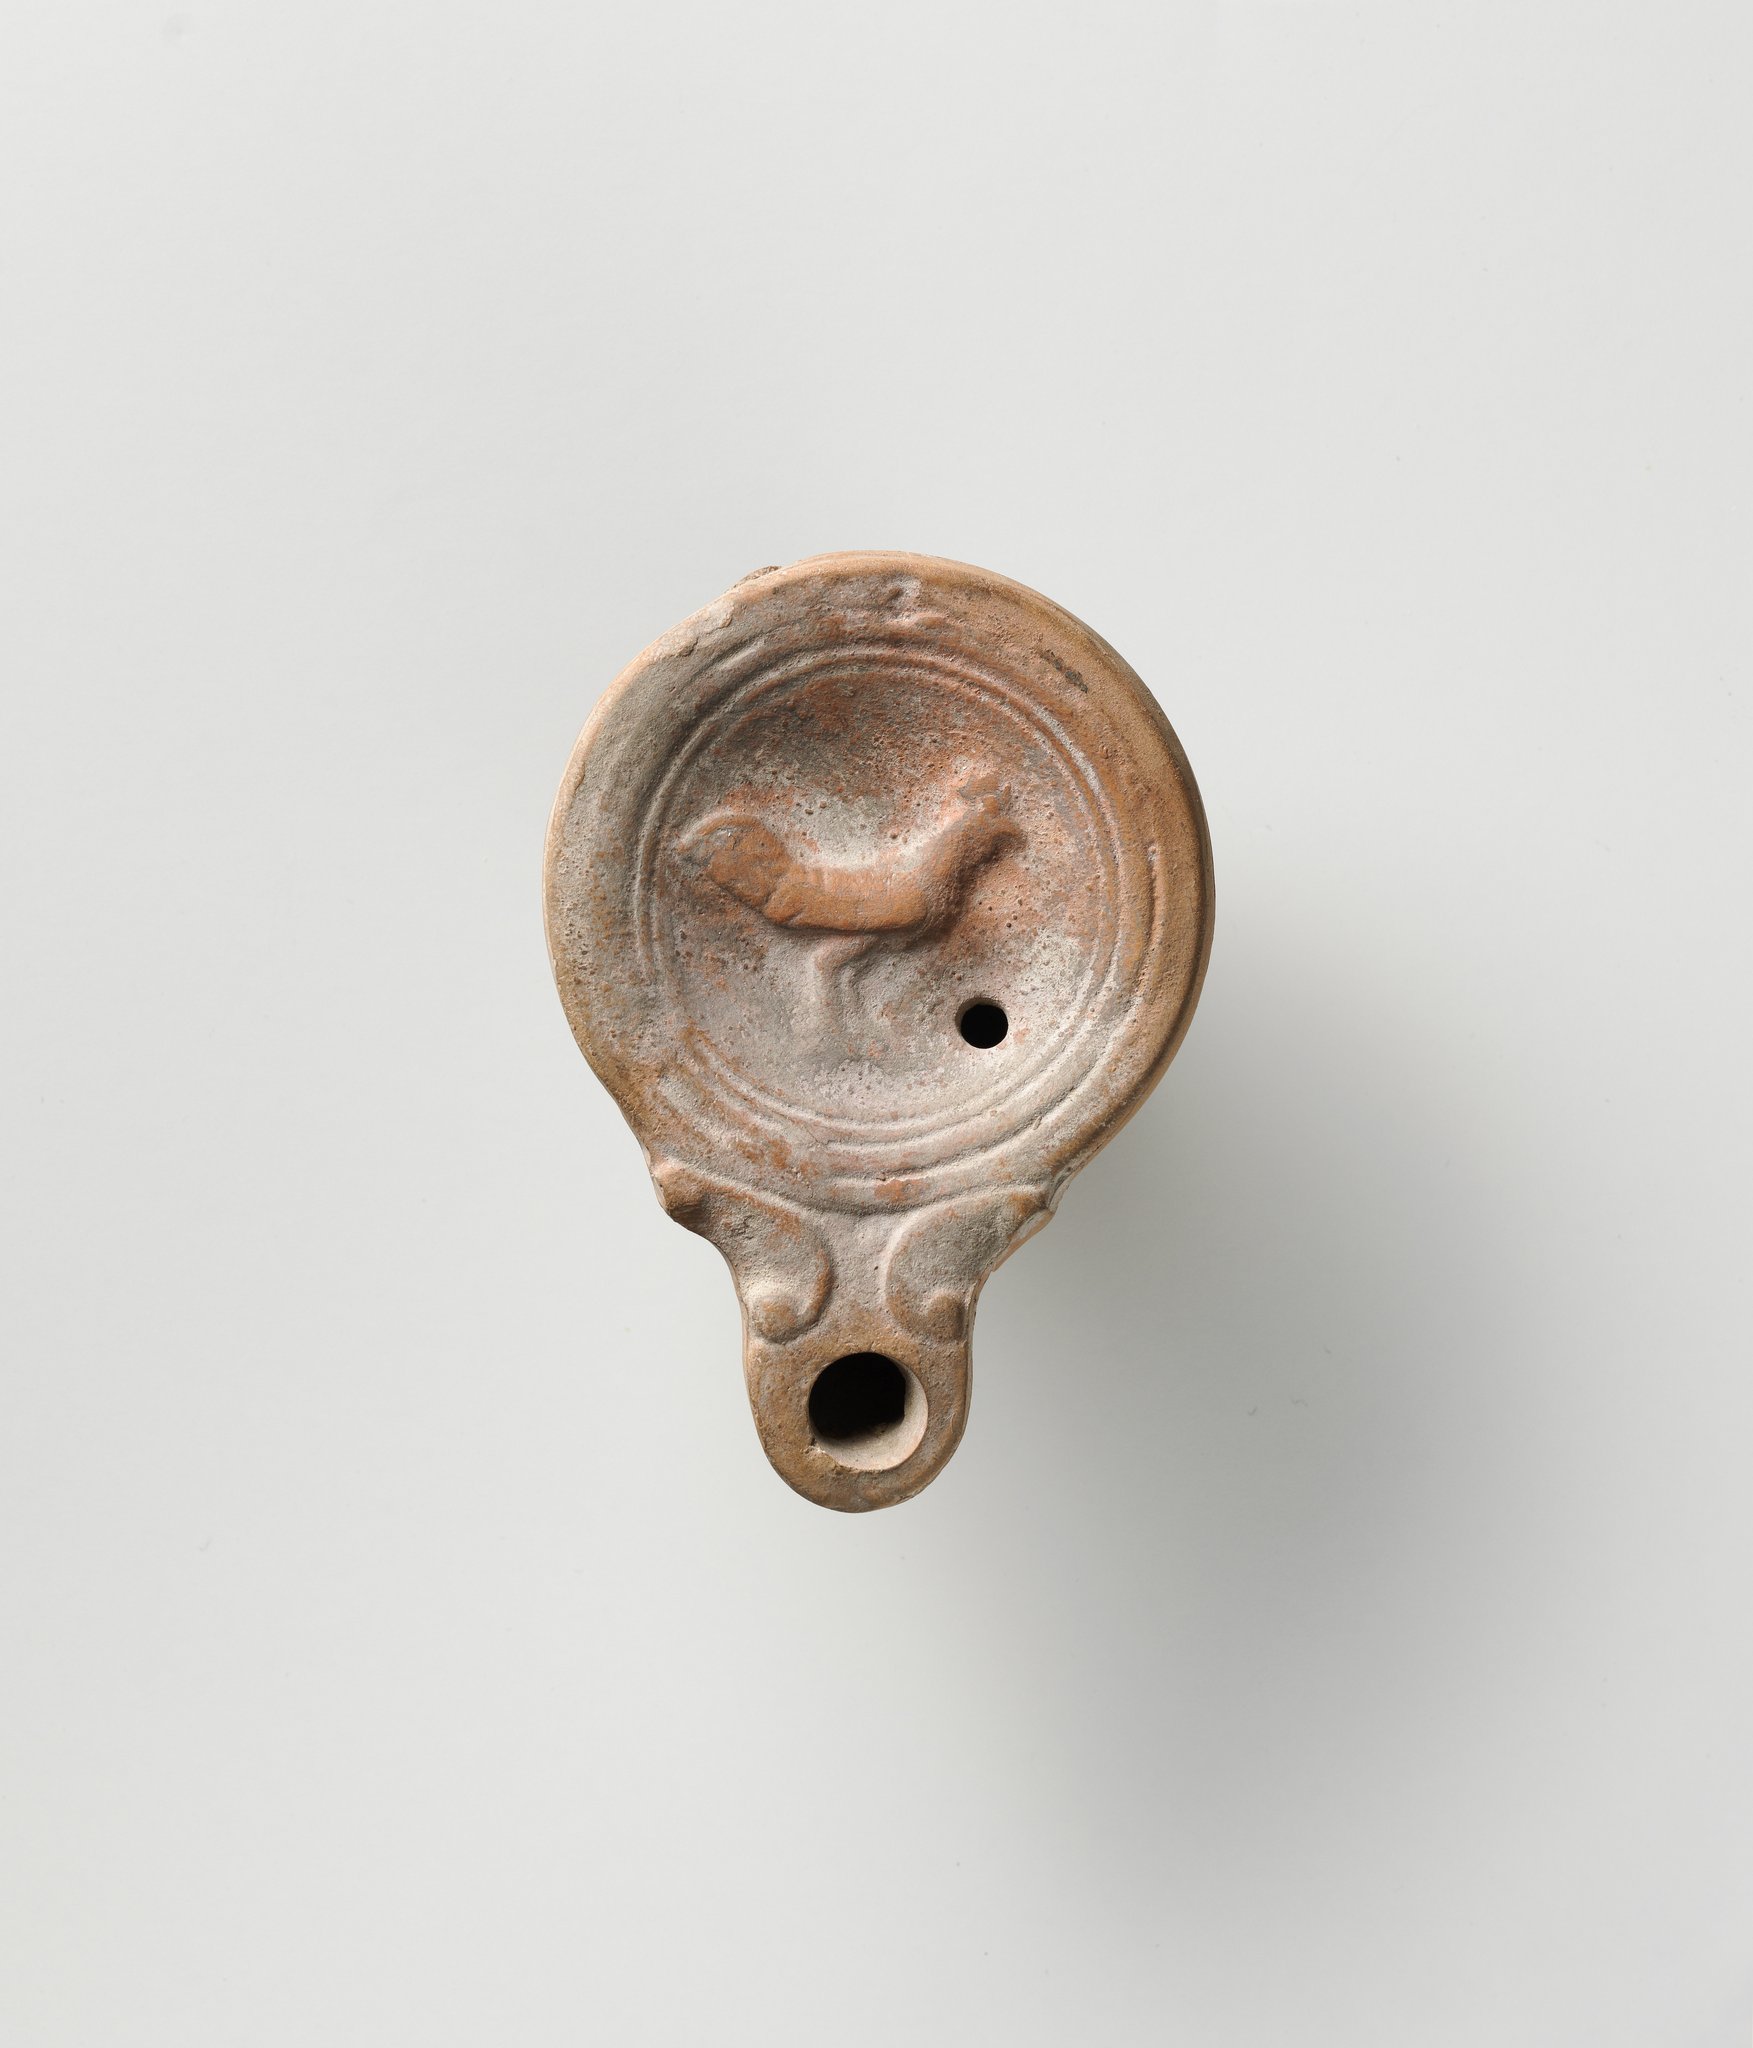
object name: lamp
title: Terracotta oil lamp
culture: roman, cypriot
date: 40-100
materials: terracotta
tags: roosters